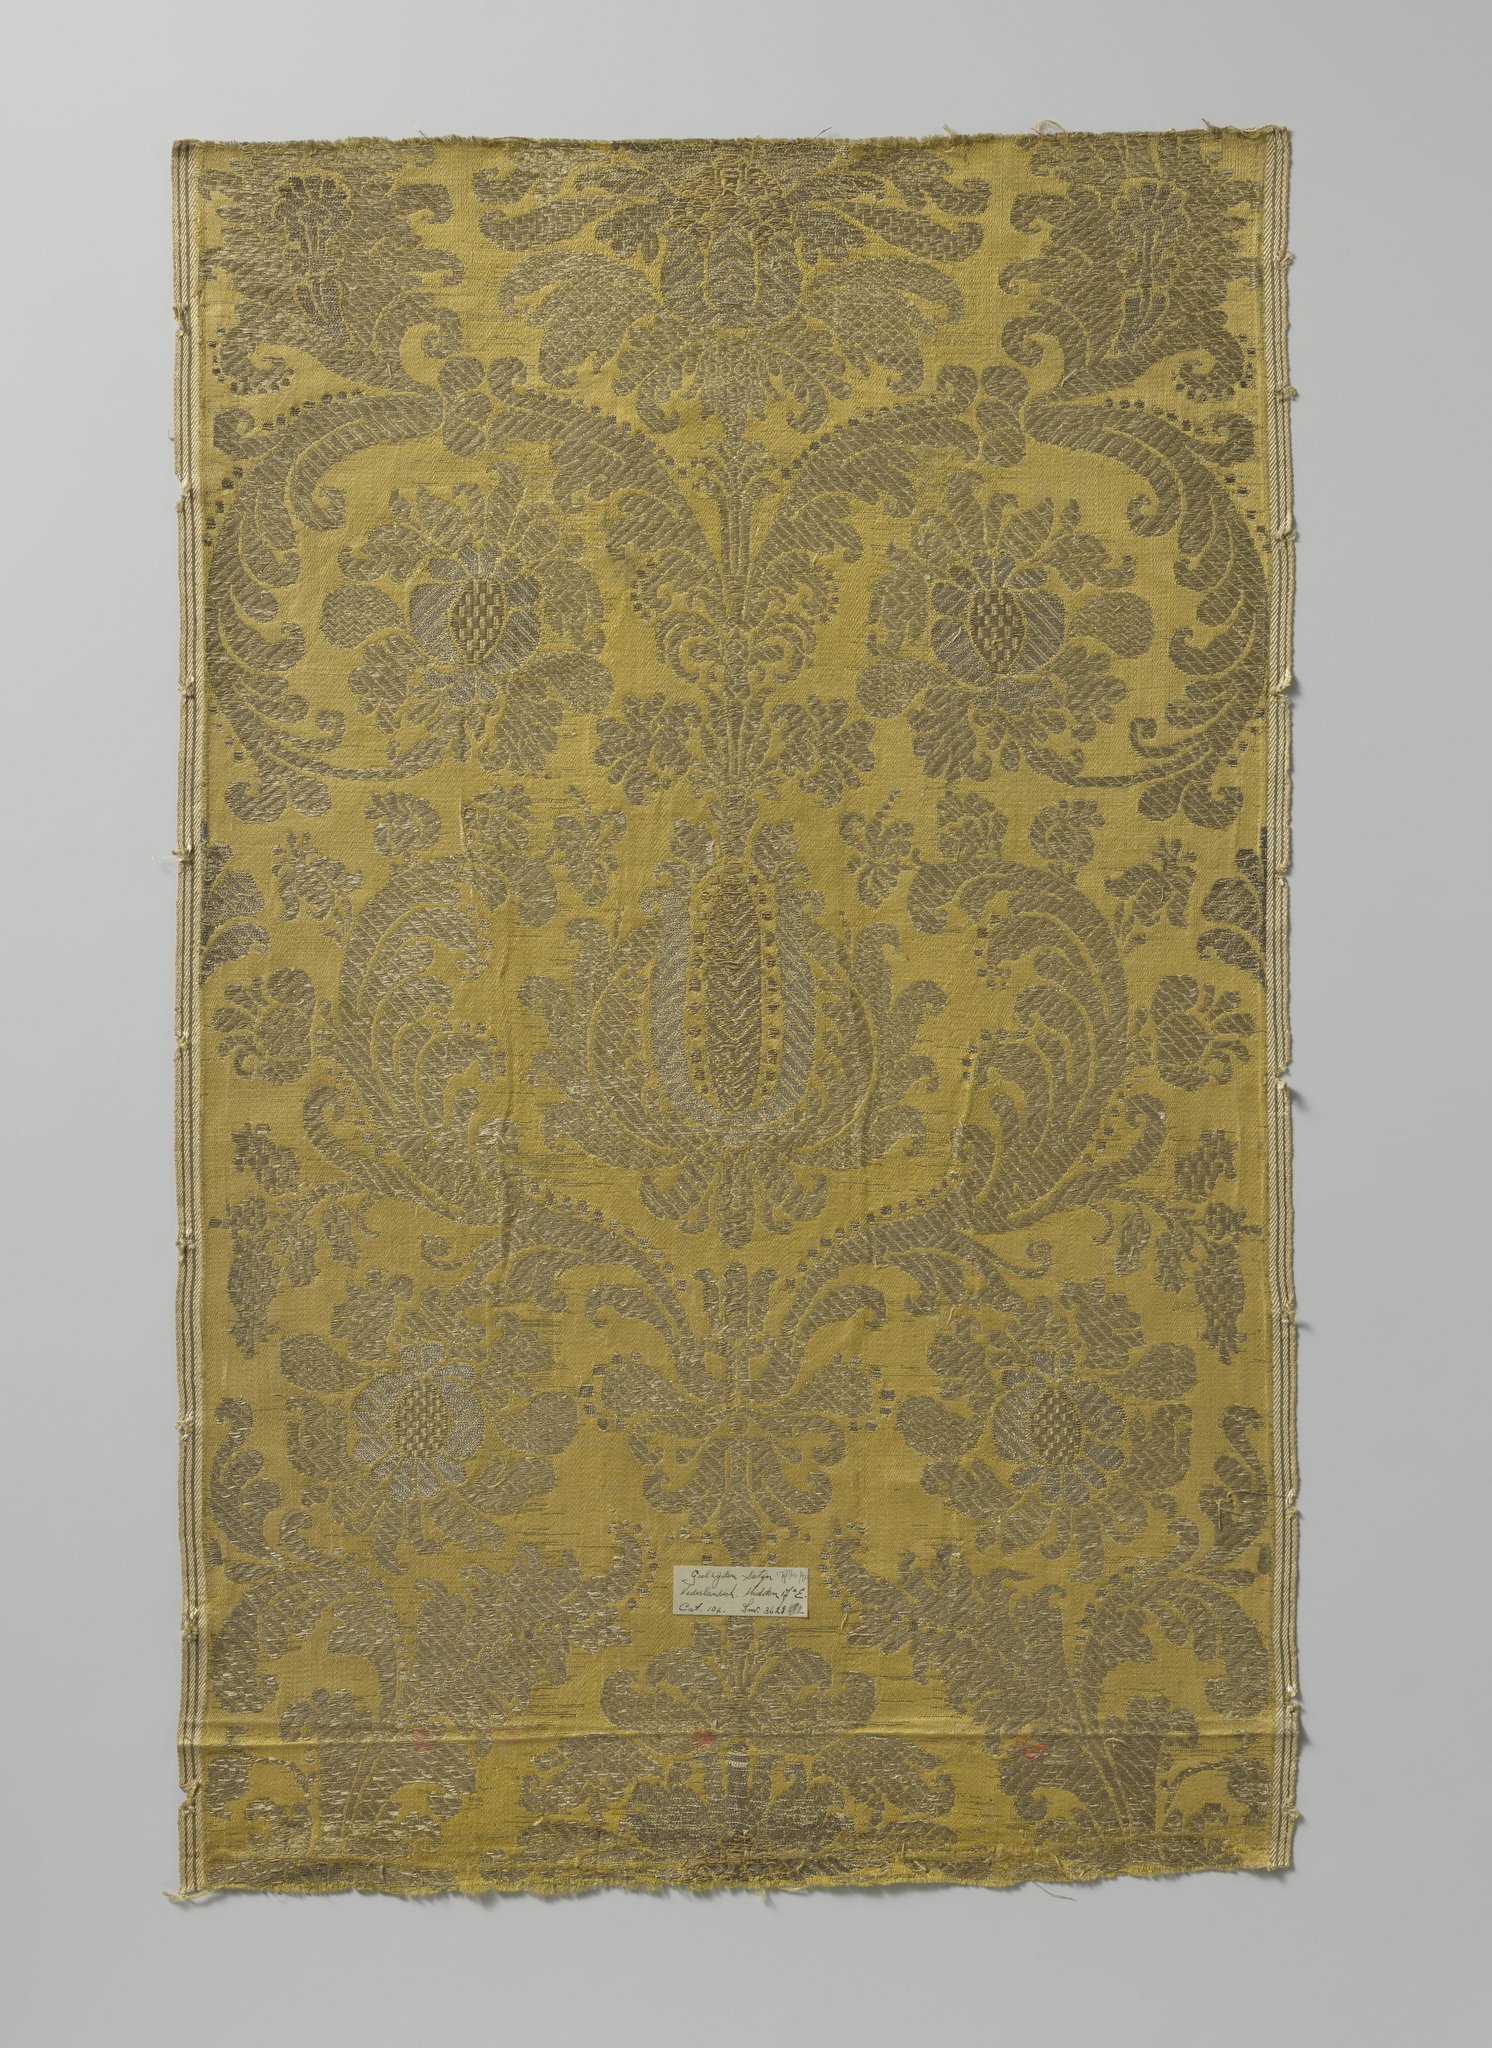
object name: zijdesatijn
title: Fragment zijdeweefsel met goud- en zilverdraad op een gele grond. Patroon van palmetten, acanthusbladeren, gestileerde bloemen en granaatappels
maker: Anonymous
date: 1675-1685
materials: silk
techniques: brocade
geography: italy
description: Een frgament zijdeweefsel met een symmetrisch patroon in goud- en zilverdraad op een gele grond. Het patroon heeft palmetten en acanthusbladeren die zich slingeren om gestileerde bloemen en granaatappels.